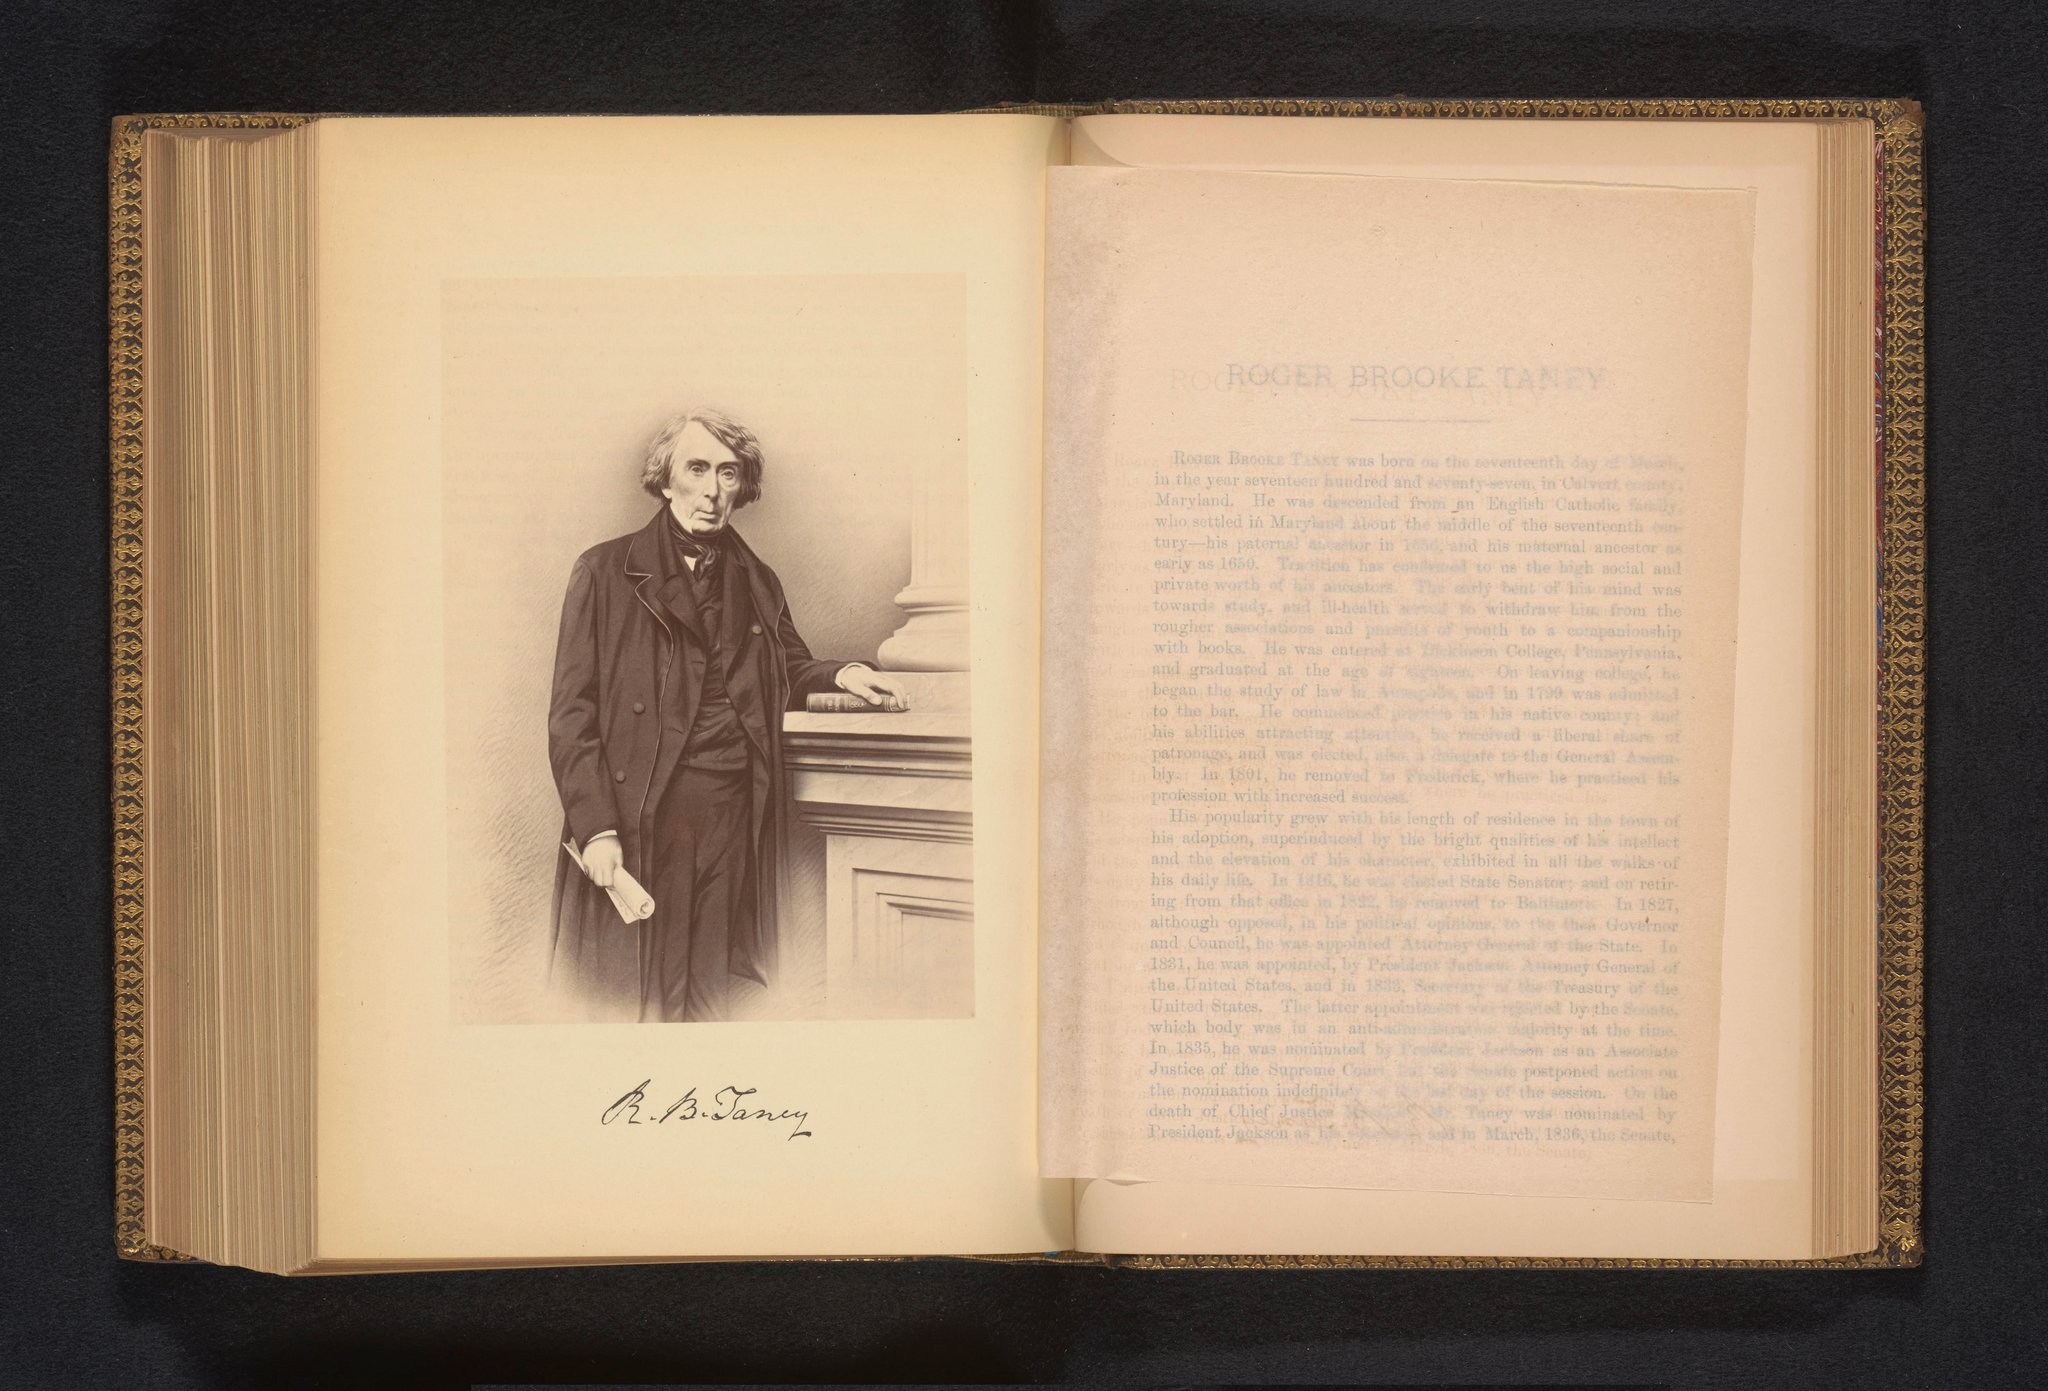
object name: reproduction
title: Fotoreproductie van een portret van Roger Brooke Taney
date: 1866-1871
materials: photographic support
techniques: albumen print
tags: historical persons